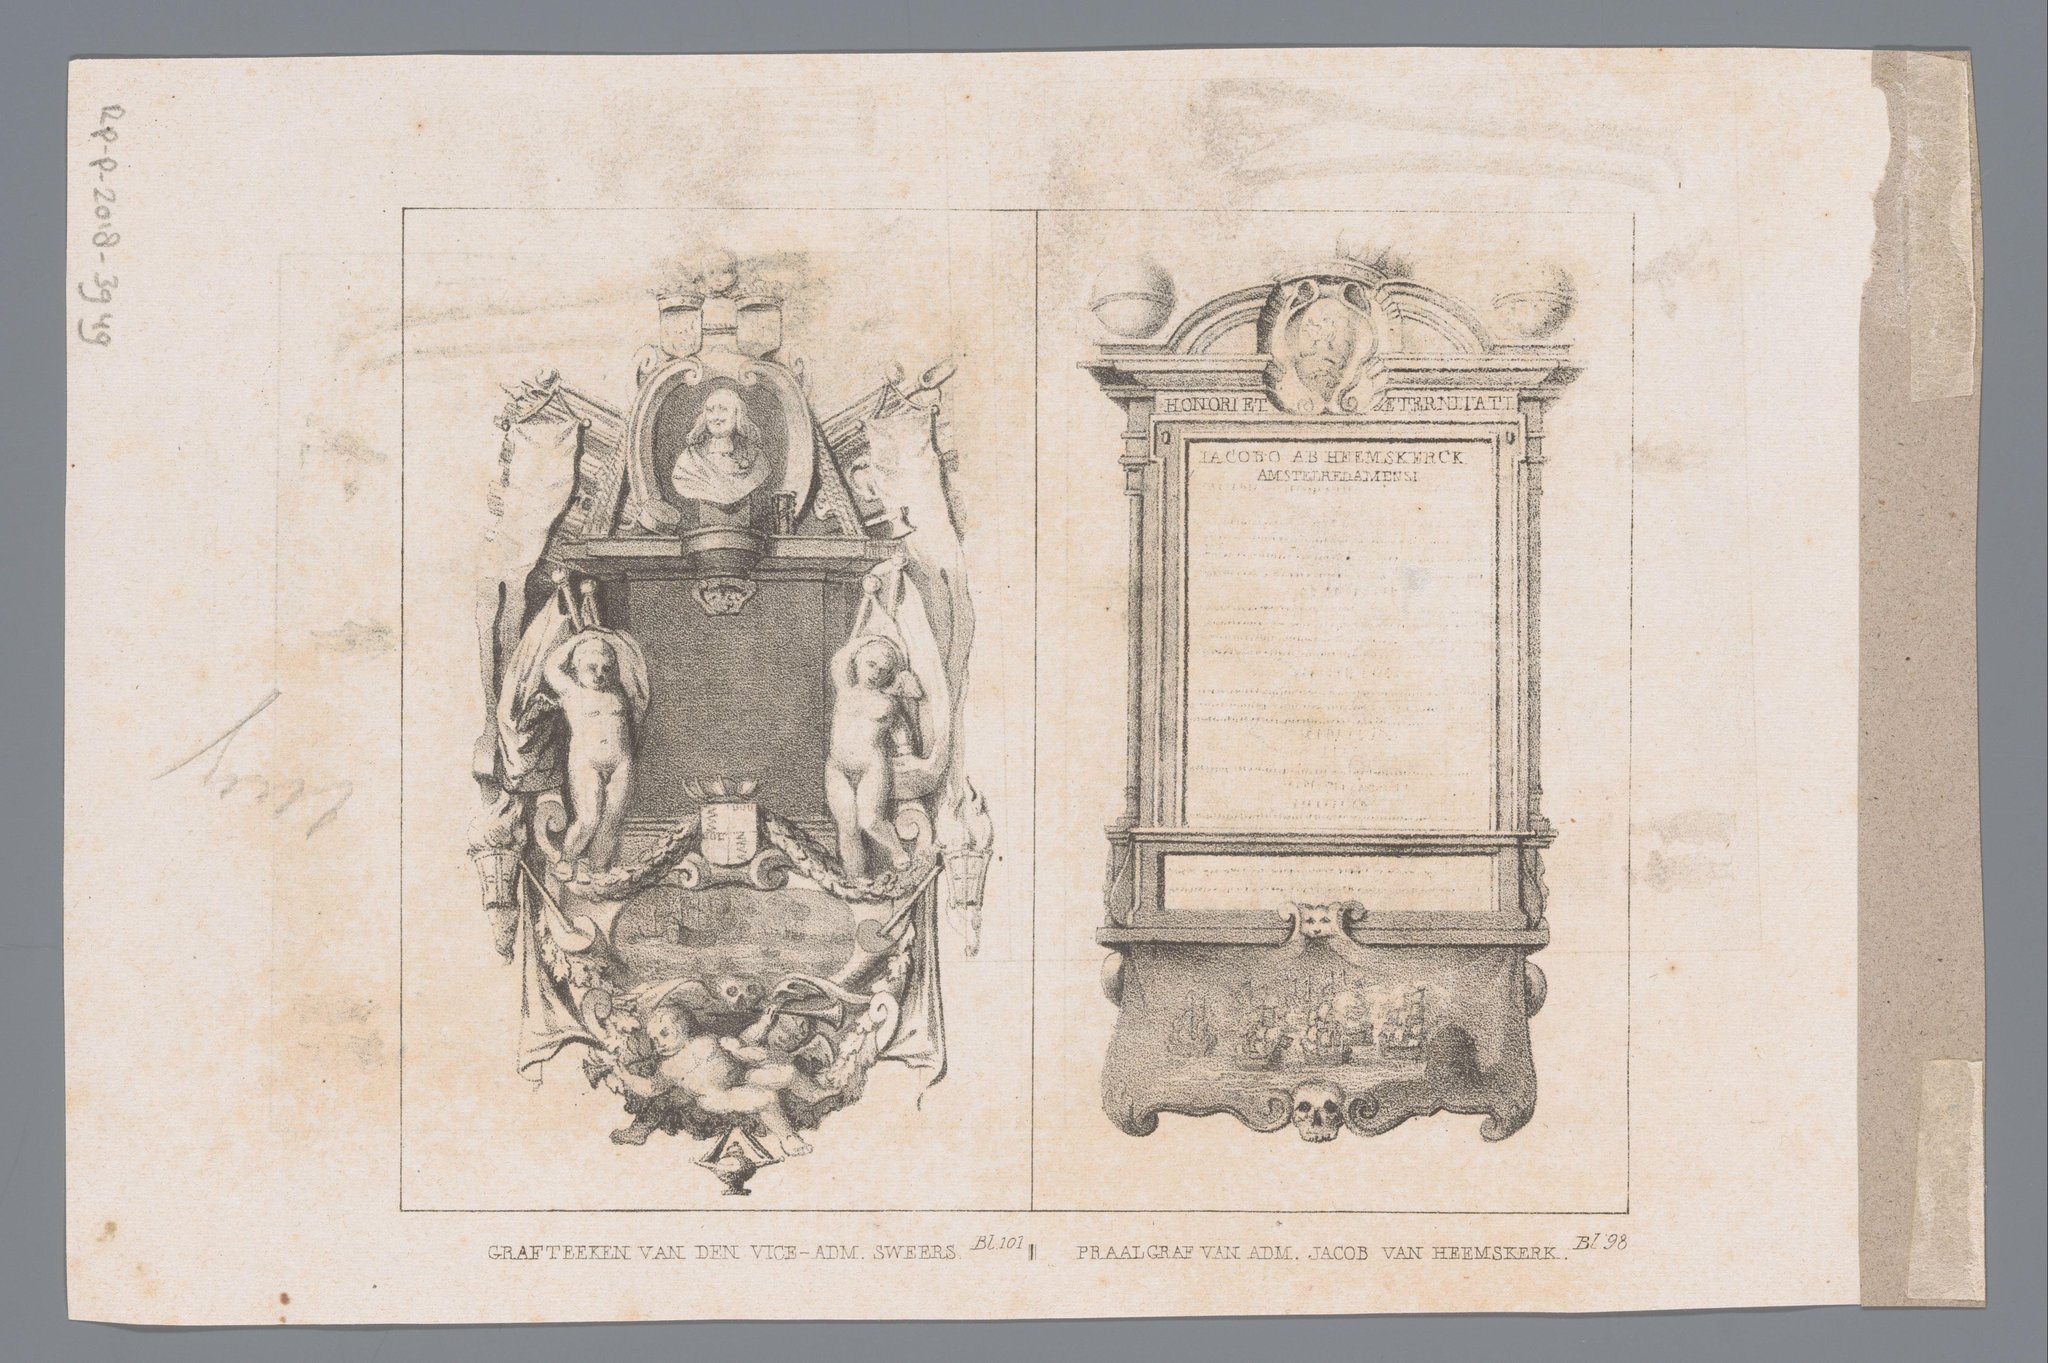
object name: print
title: Grafteeken van den Vice-Adm. Sweers / Praalgraf van Adm. Jacob van Heemskerck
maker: johannes hilverdink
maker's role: draughtsman, painter, print maker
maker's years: 1813-1902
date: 1848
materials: paper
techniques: lithograph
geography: amsterdam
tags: grave, tomb, amsterdam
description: Prent uit: Vijver, C. van der. Geschiedkundige beschrijving der stad Amsterdam. Amsterdam: Gebroeders Diederichs, 1848, dl. 2.